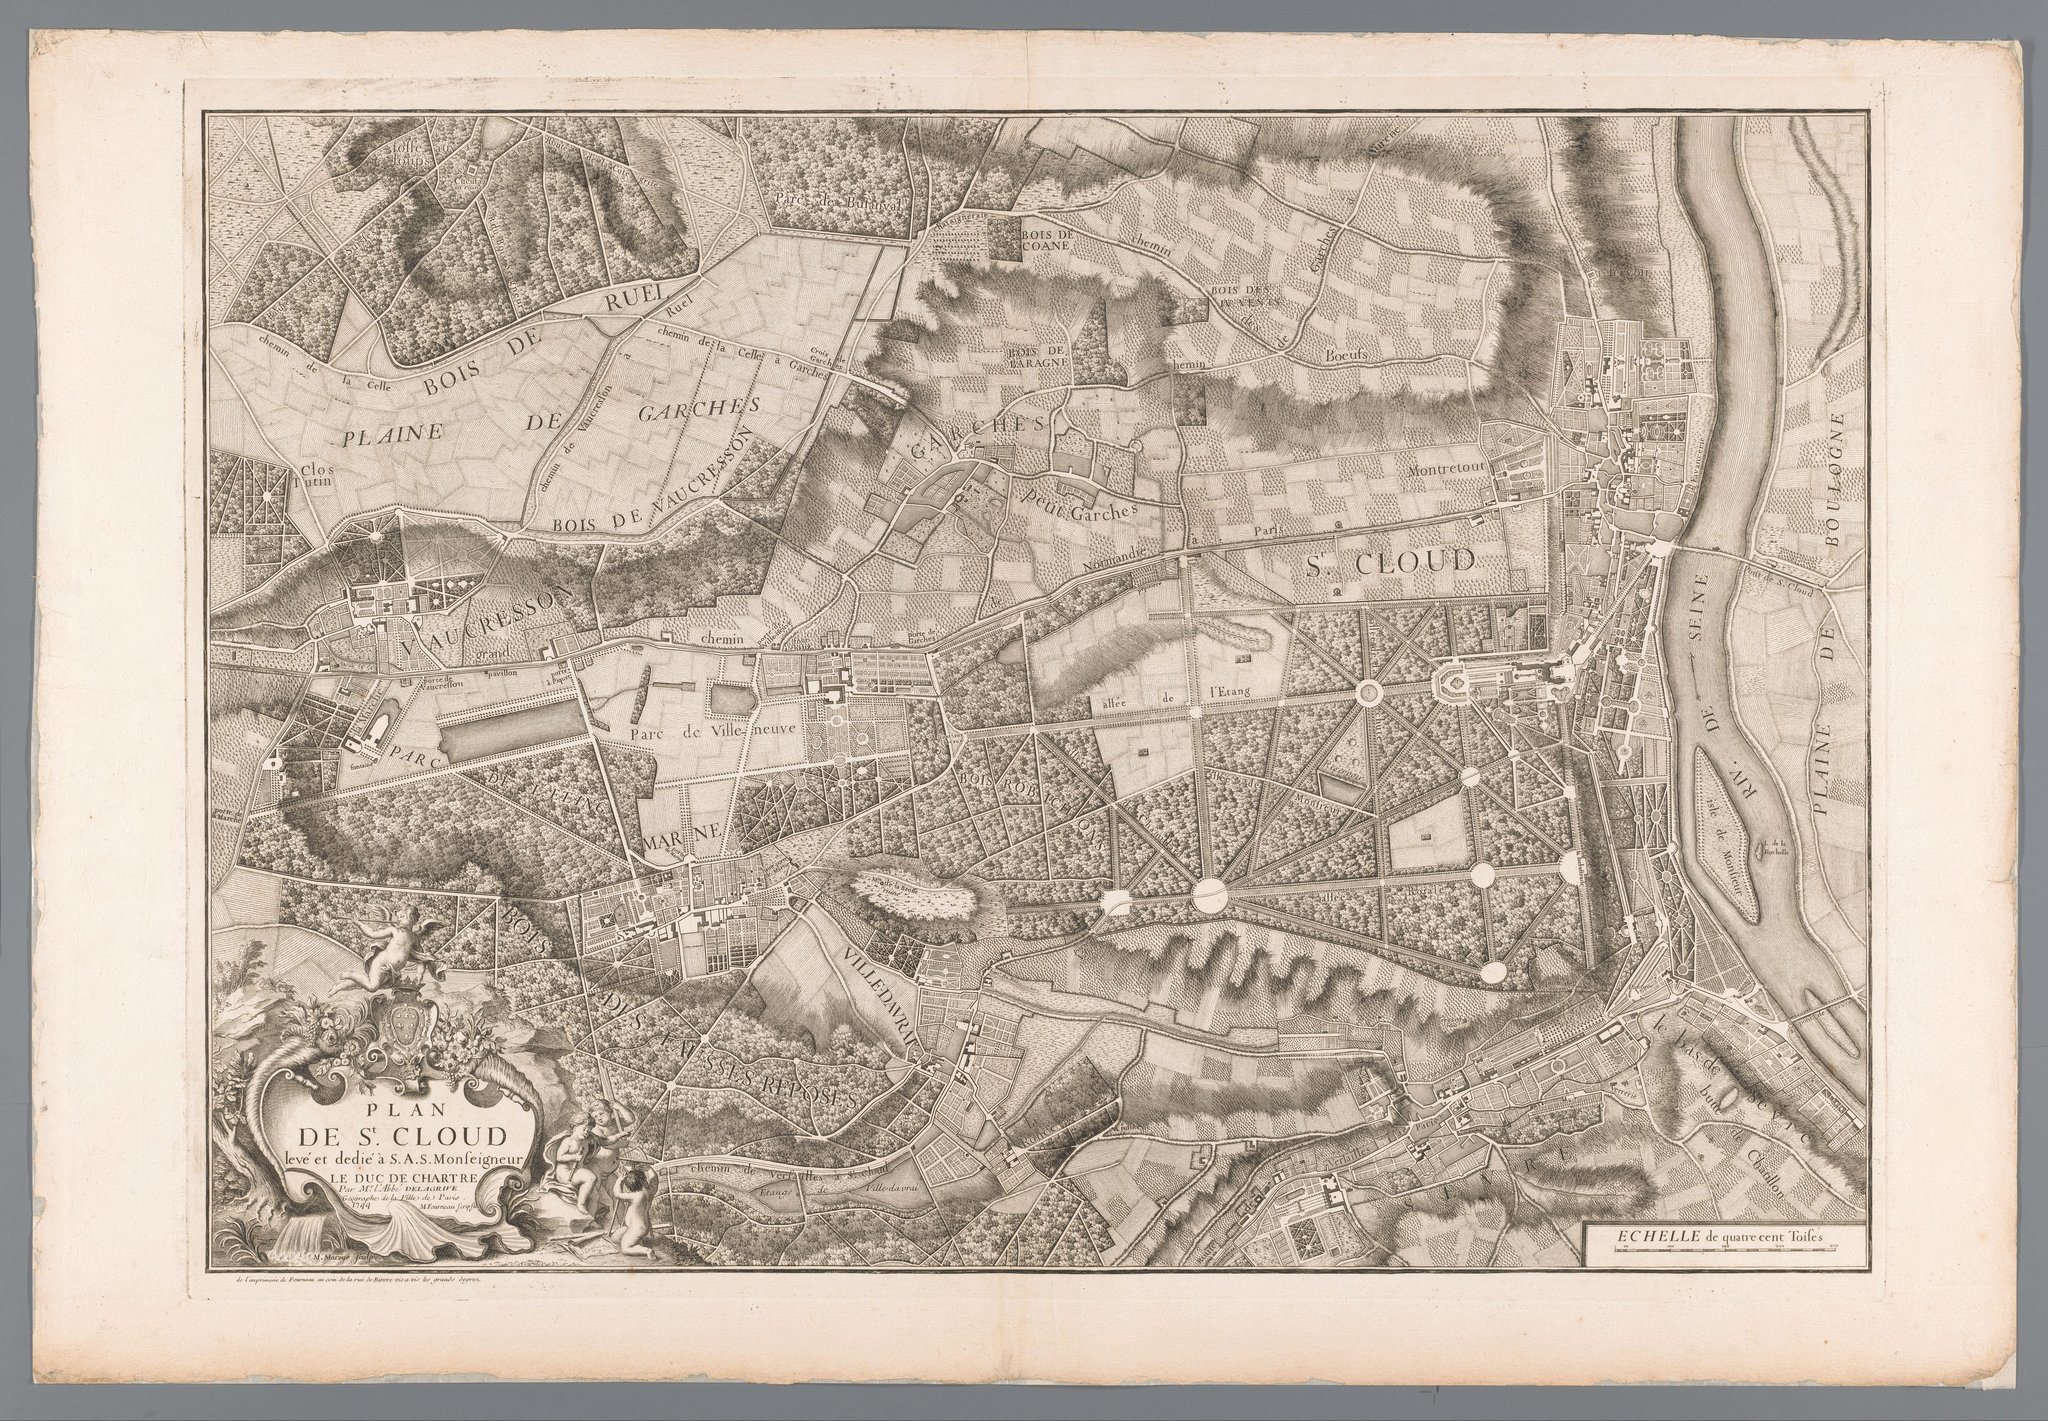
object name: area plan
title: Plan de St. Cloud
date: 1744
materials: paper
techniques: engraving, etching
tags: plan, map of garden, maps of cities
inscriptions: collector's mark: Lugt 2760, collector's mark: Lugt 2228